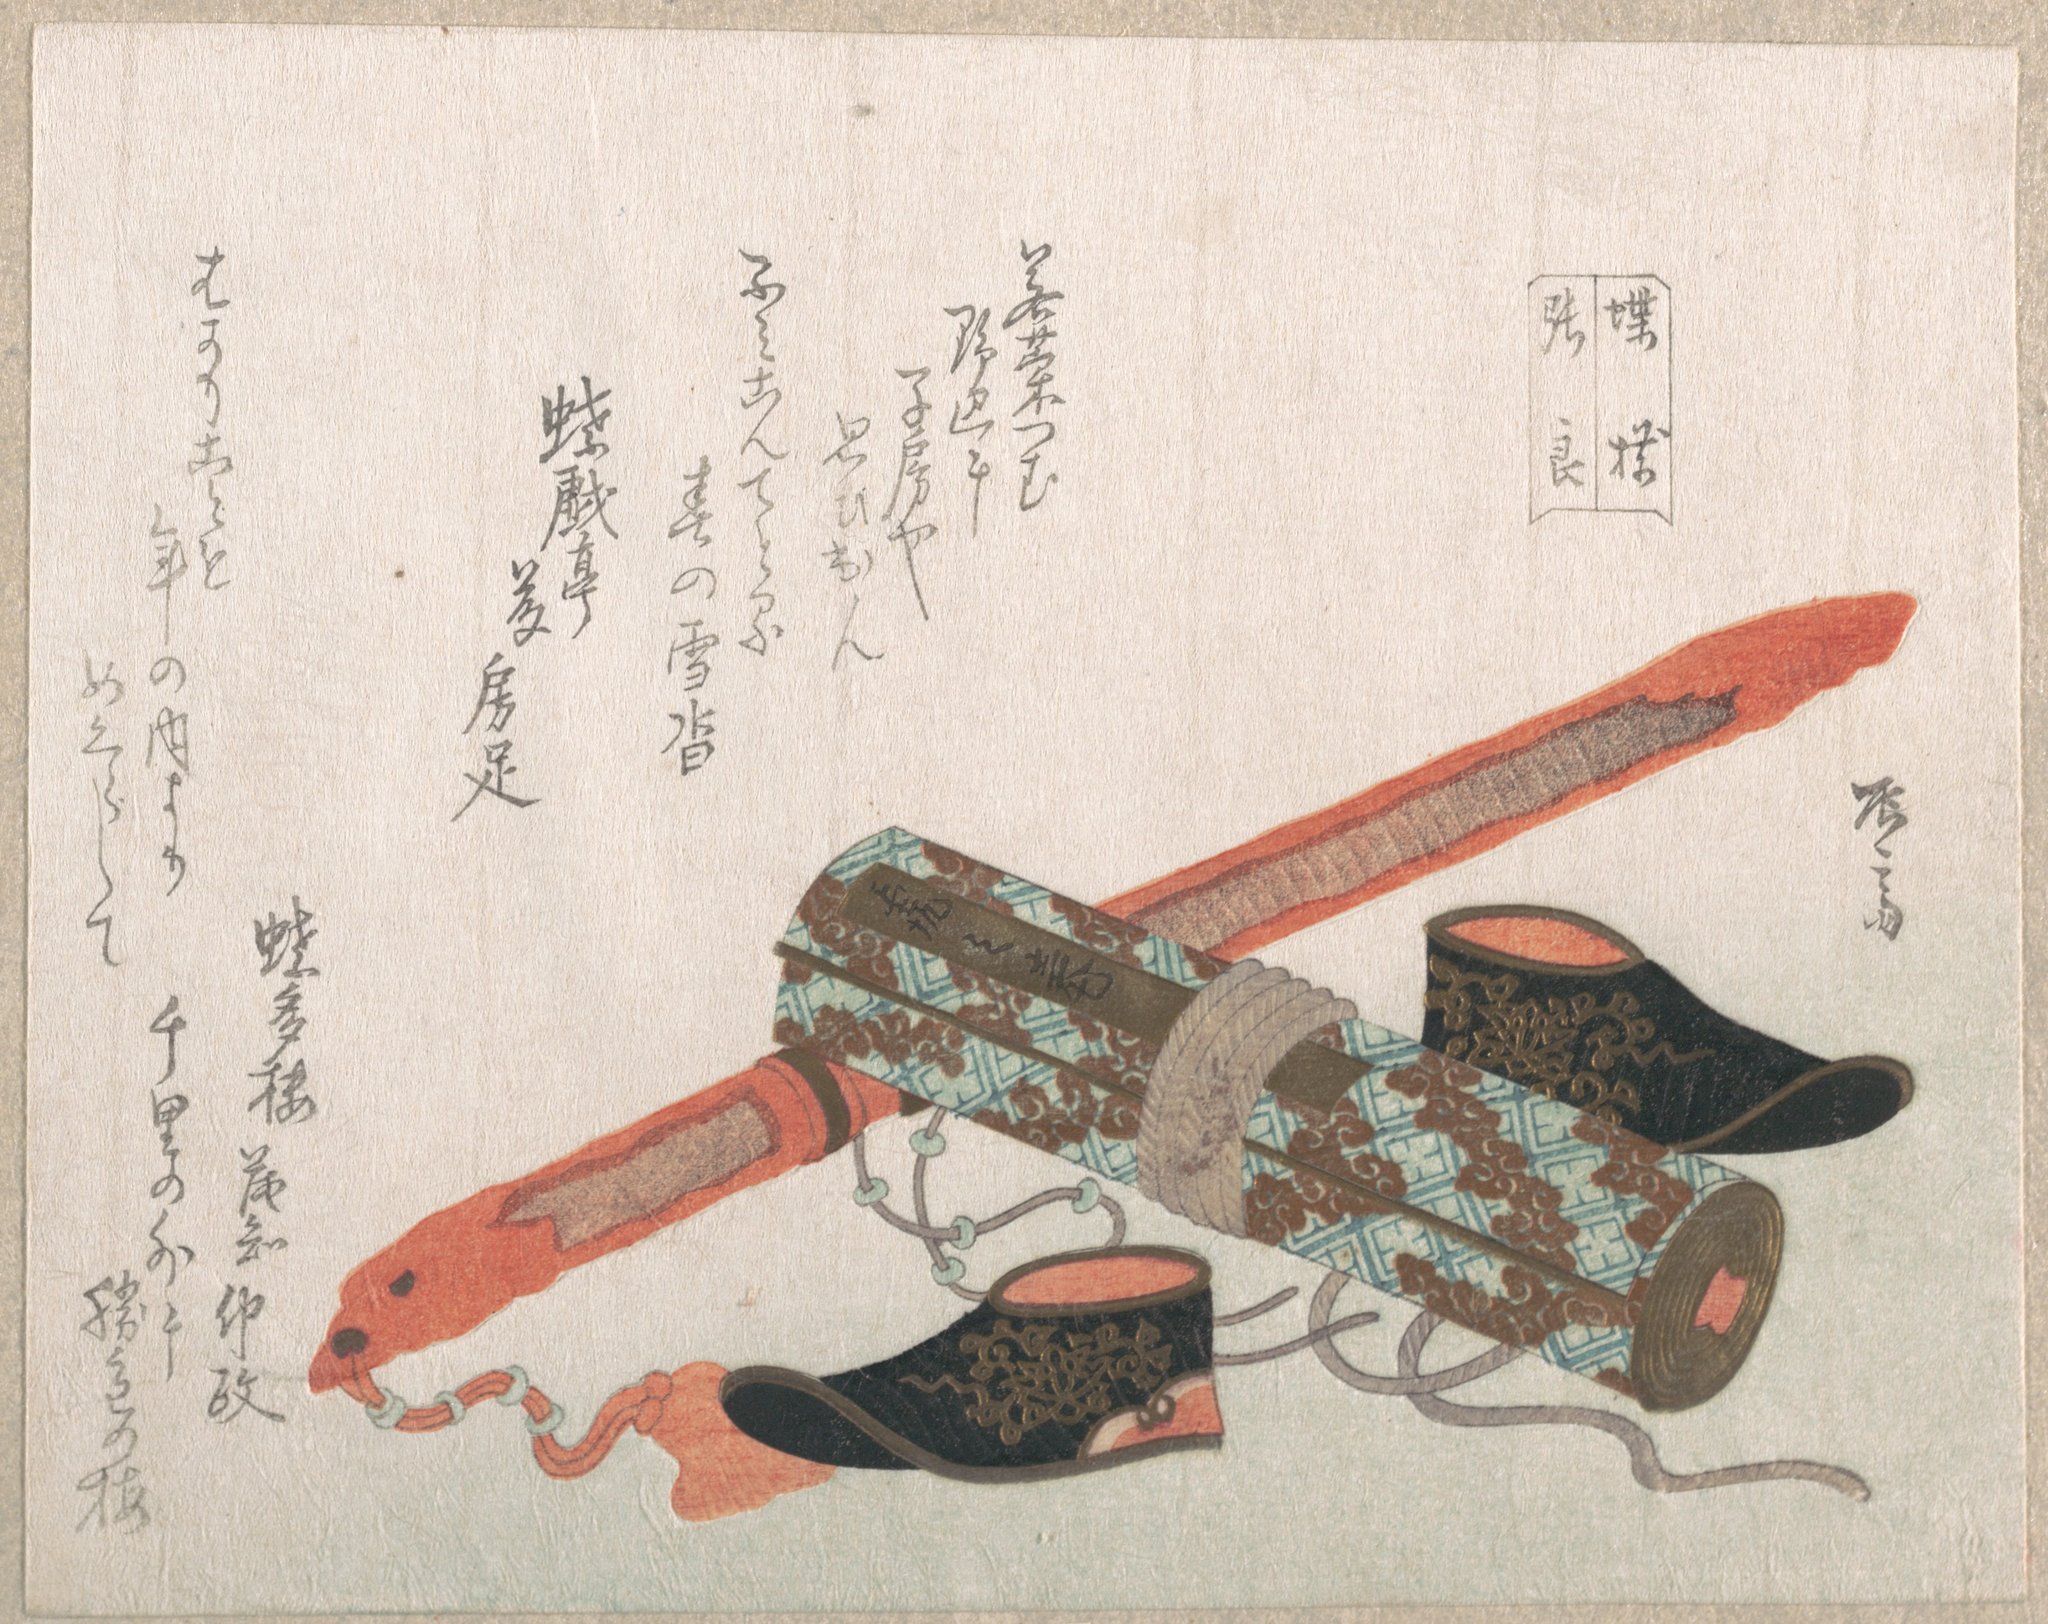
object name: woodblock print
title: Sword, Shoes and a Scroll, Representing the Chinese Warrior Chōryō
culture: japanese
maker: ryūryūkyo shinsai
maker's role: artist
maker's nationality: japanese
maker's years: 1799-1823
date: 1801-1900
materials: ink, paper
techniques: surimono, woodblock print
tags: scrolls,shoes,swords